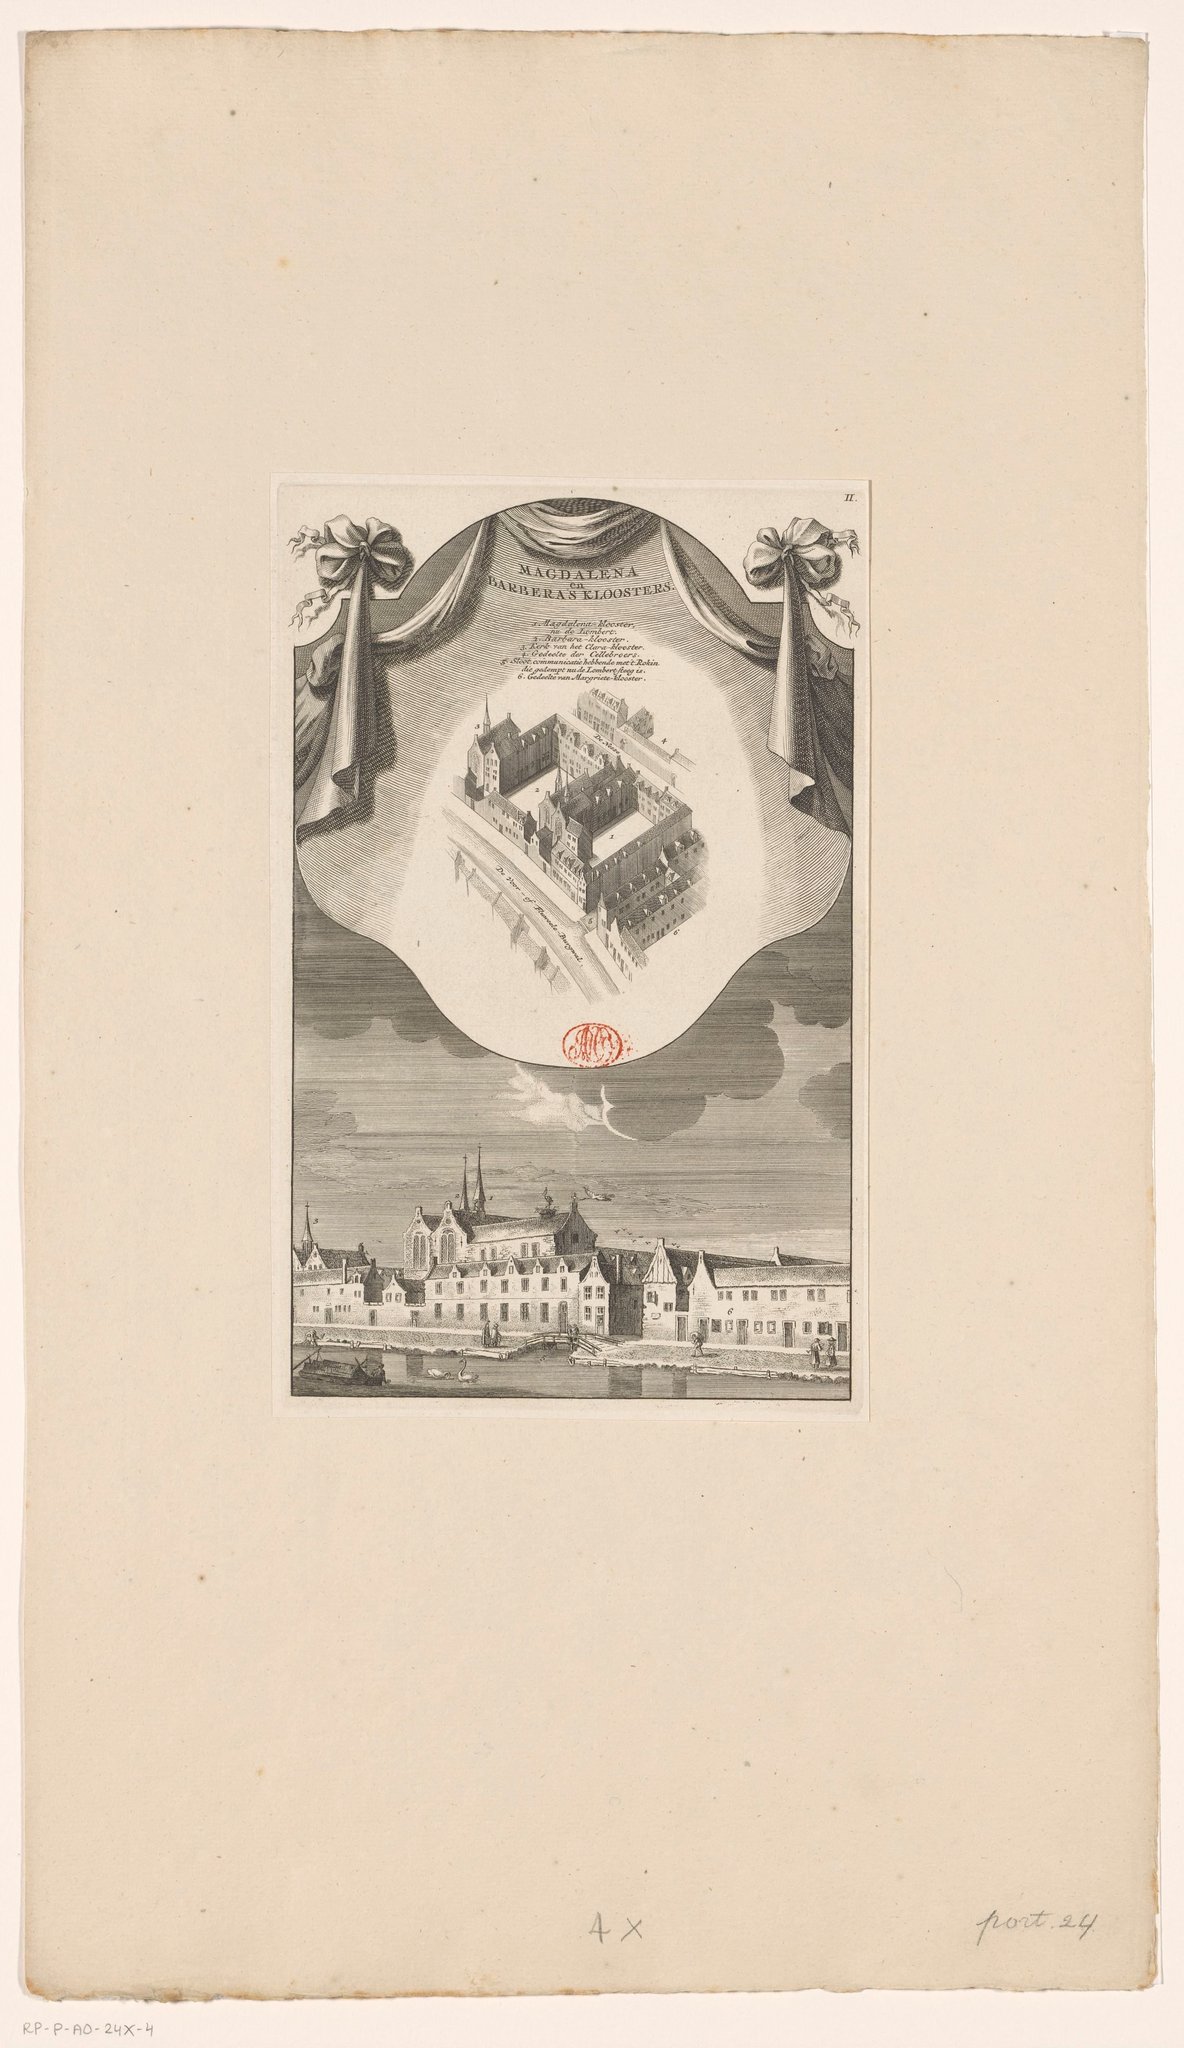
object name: print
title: Gezichten op het Sint-Maria Magdalenaklooster en het Sint-Barbaraklooster te Amsterdam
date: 1760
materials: paper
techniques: engraving, etching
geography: amsterdam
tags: abbey, monastery, convent ~ roman catholic church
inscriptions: collector's mark: Lugt 195, collector's mark: Lugt 2233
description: Prent ook gebruikt in: Wagenaar, Jan. Amsterdam, in zyne opkomst, aanwas, geschiedenissen (…). 3 delen [folio-uitgave]. Amsterdam: Isaak Tirion en Yntema & Tieboel, 1760-1767, dl. 1 (Isaac Tirion, 1760). Zie RP-P-AO-24X-5 voor proefdruk. Dat de prent de situatie rond 1544 weergeeft gaat terug op het feit dat voor het maken van deze en andere prenten van kloosters en kerken van voor de Alteratie (1578) is uitgegaan van de plattegrond van Cornelis Anthonisz. uit 1544 (zie RP-P-OB-70.399 en RP-P-AO-20-15).